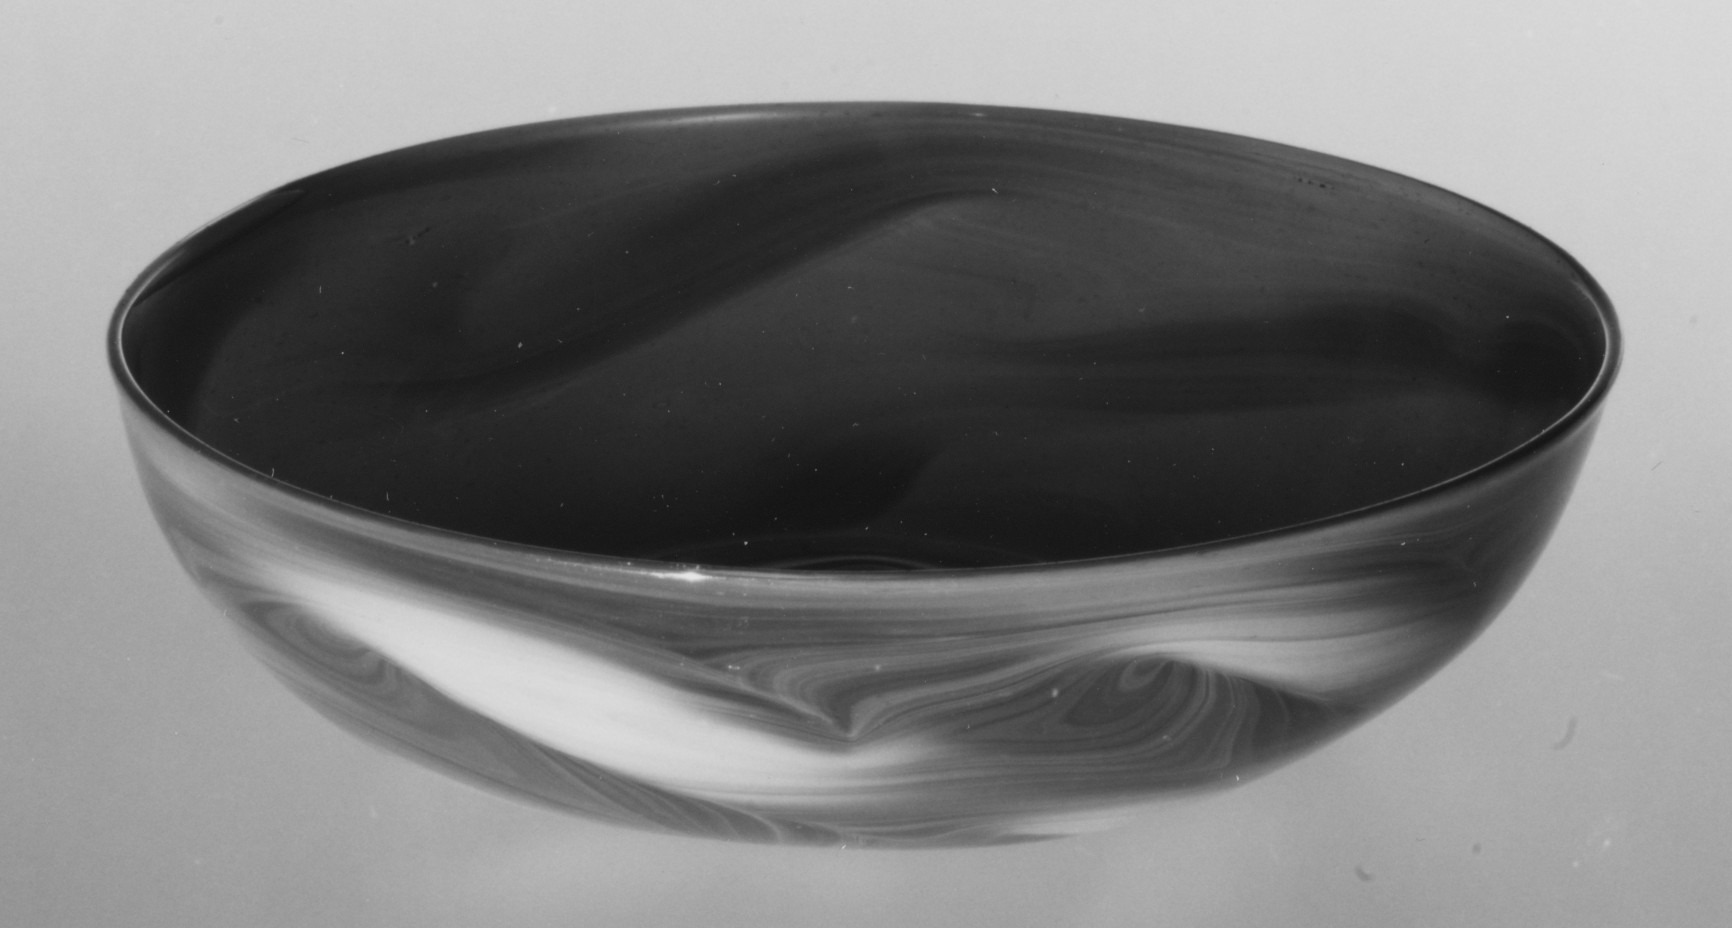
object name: bowl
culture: italian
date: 1867-1900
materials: amber, glass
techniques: glassblowing